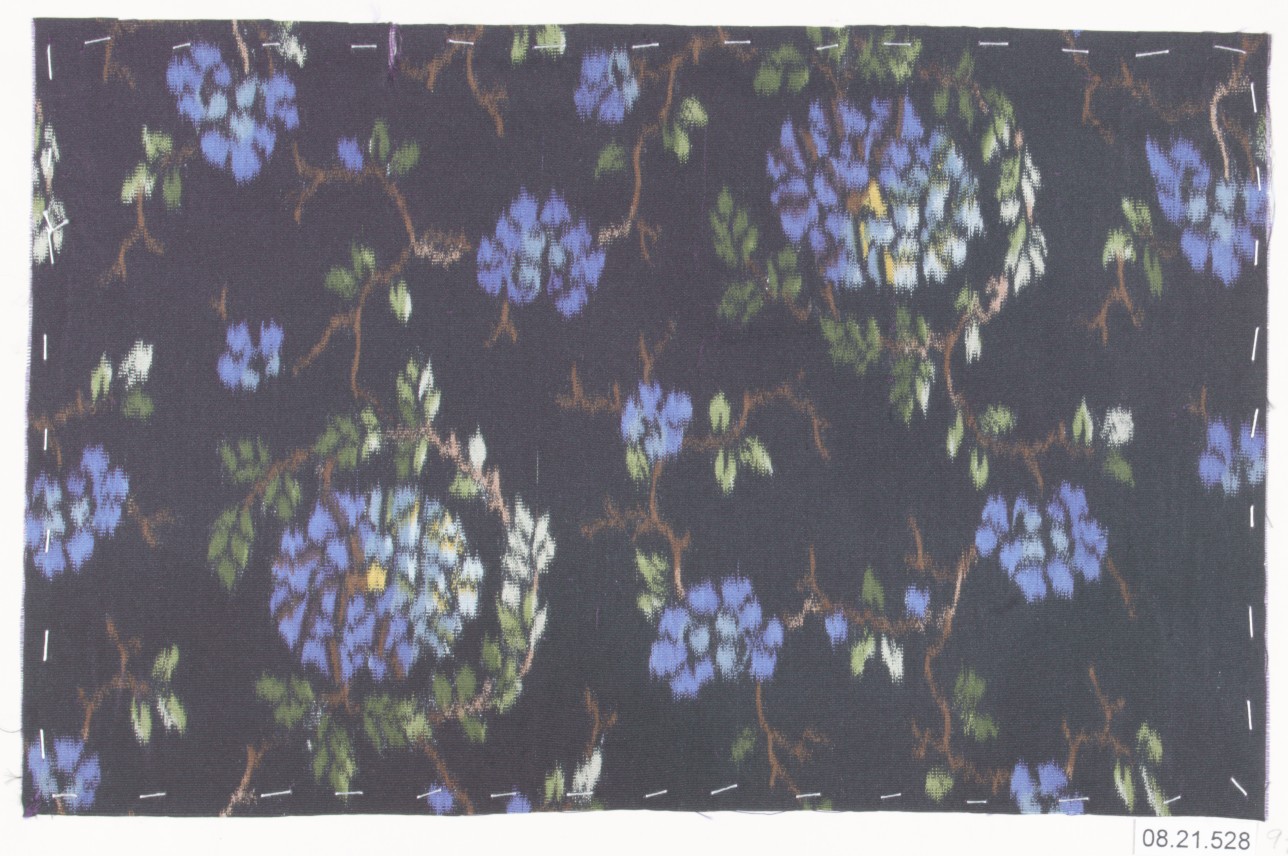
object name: textile sample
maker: Anonymous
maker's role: designer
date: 1900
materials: silk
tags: flowers